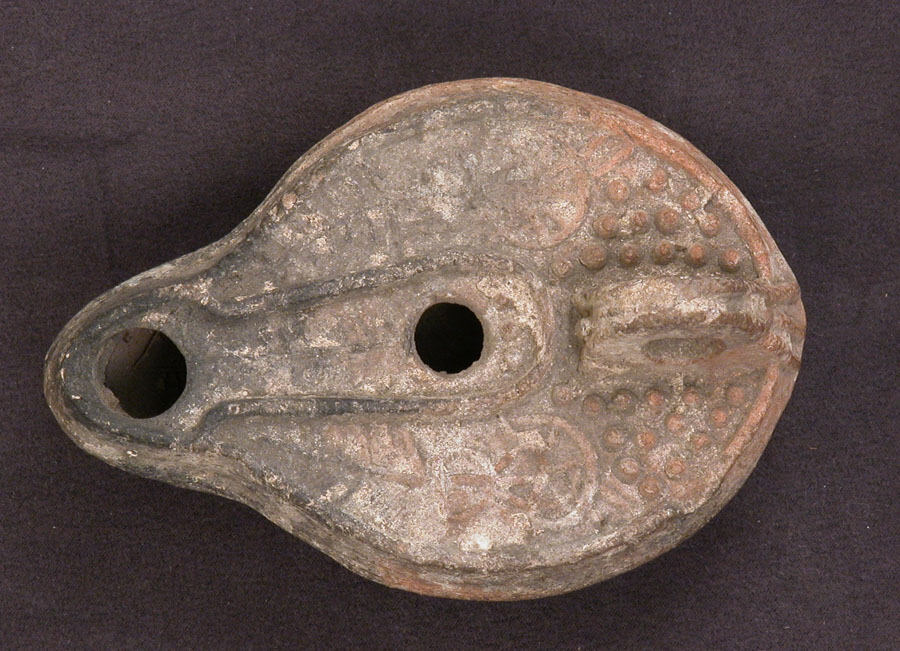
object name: lamp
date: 301-400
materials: earthenware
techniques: molding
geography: egypt